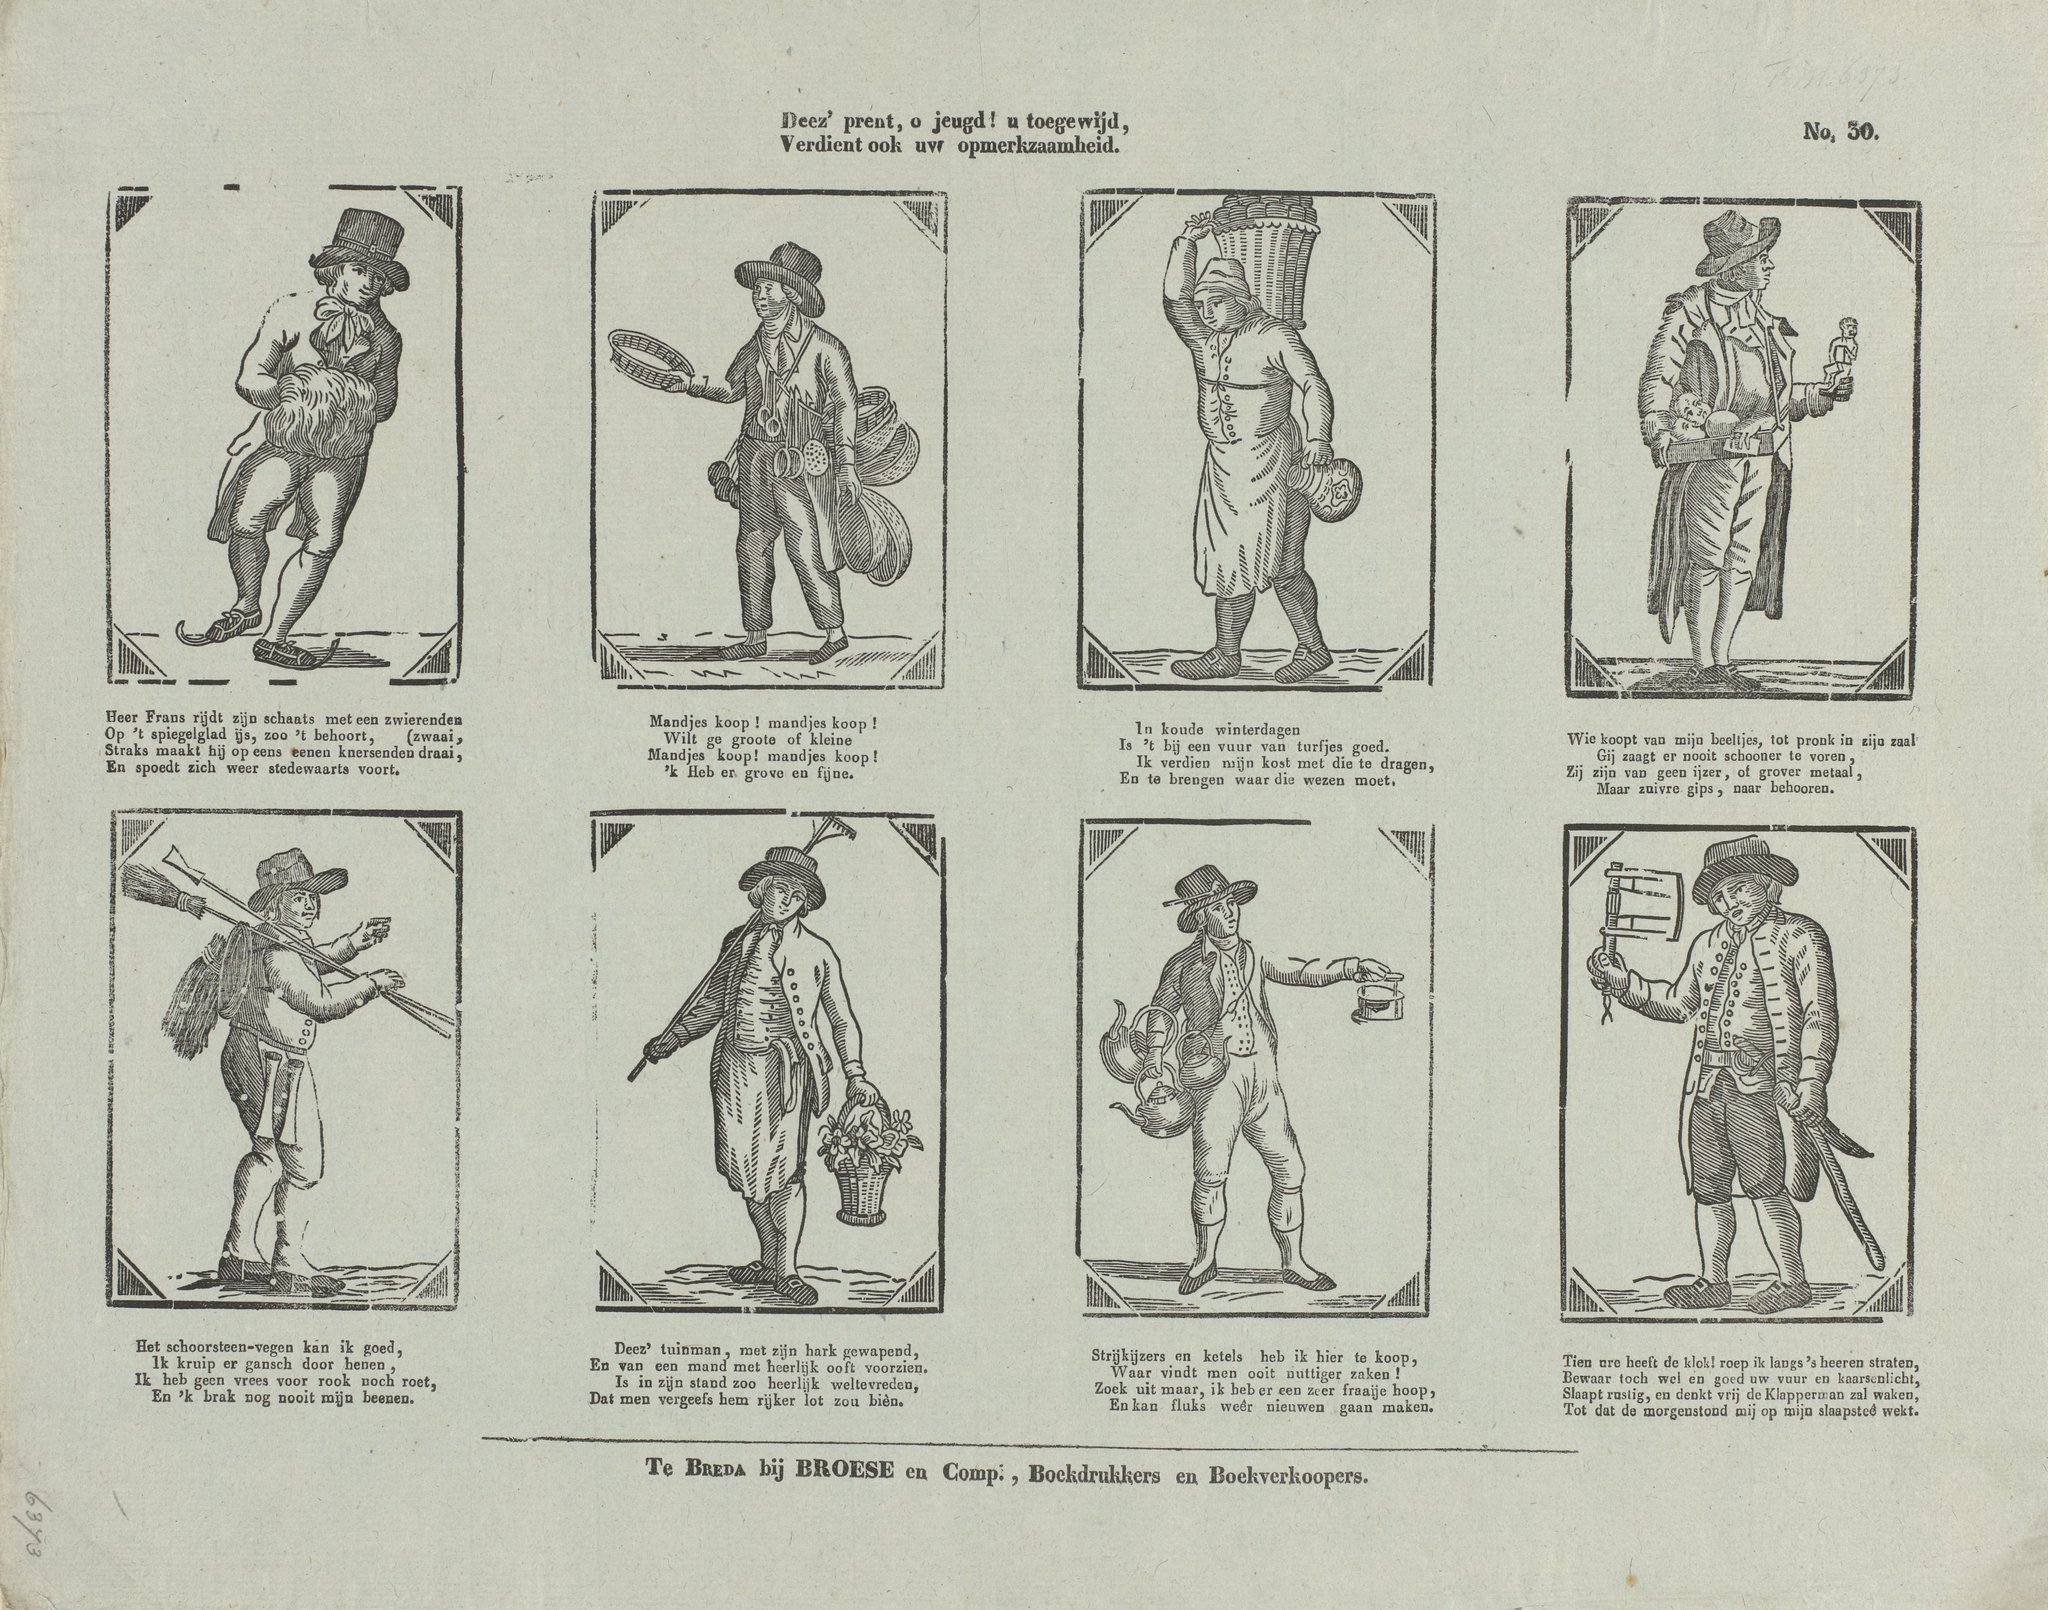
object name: print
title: Deez' prent, o jeugd! u toegewijd, / Verdient ook uw opmerkzaamheid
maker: Anonymous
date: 1828-1853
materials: paper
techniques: letterpress printing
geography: breda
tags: amusement, skates (winter sports), gardening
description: Blad met 8 voorstellingen van ambachtslieden en beroepen, zoals beeldenverkoper, mandenverkoper en tuinman. Onder elke afbeelding een vierregelig vers. Genummerd rechtsboven No. 30.